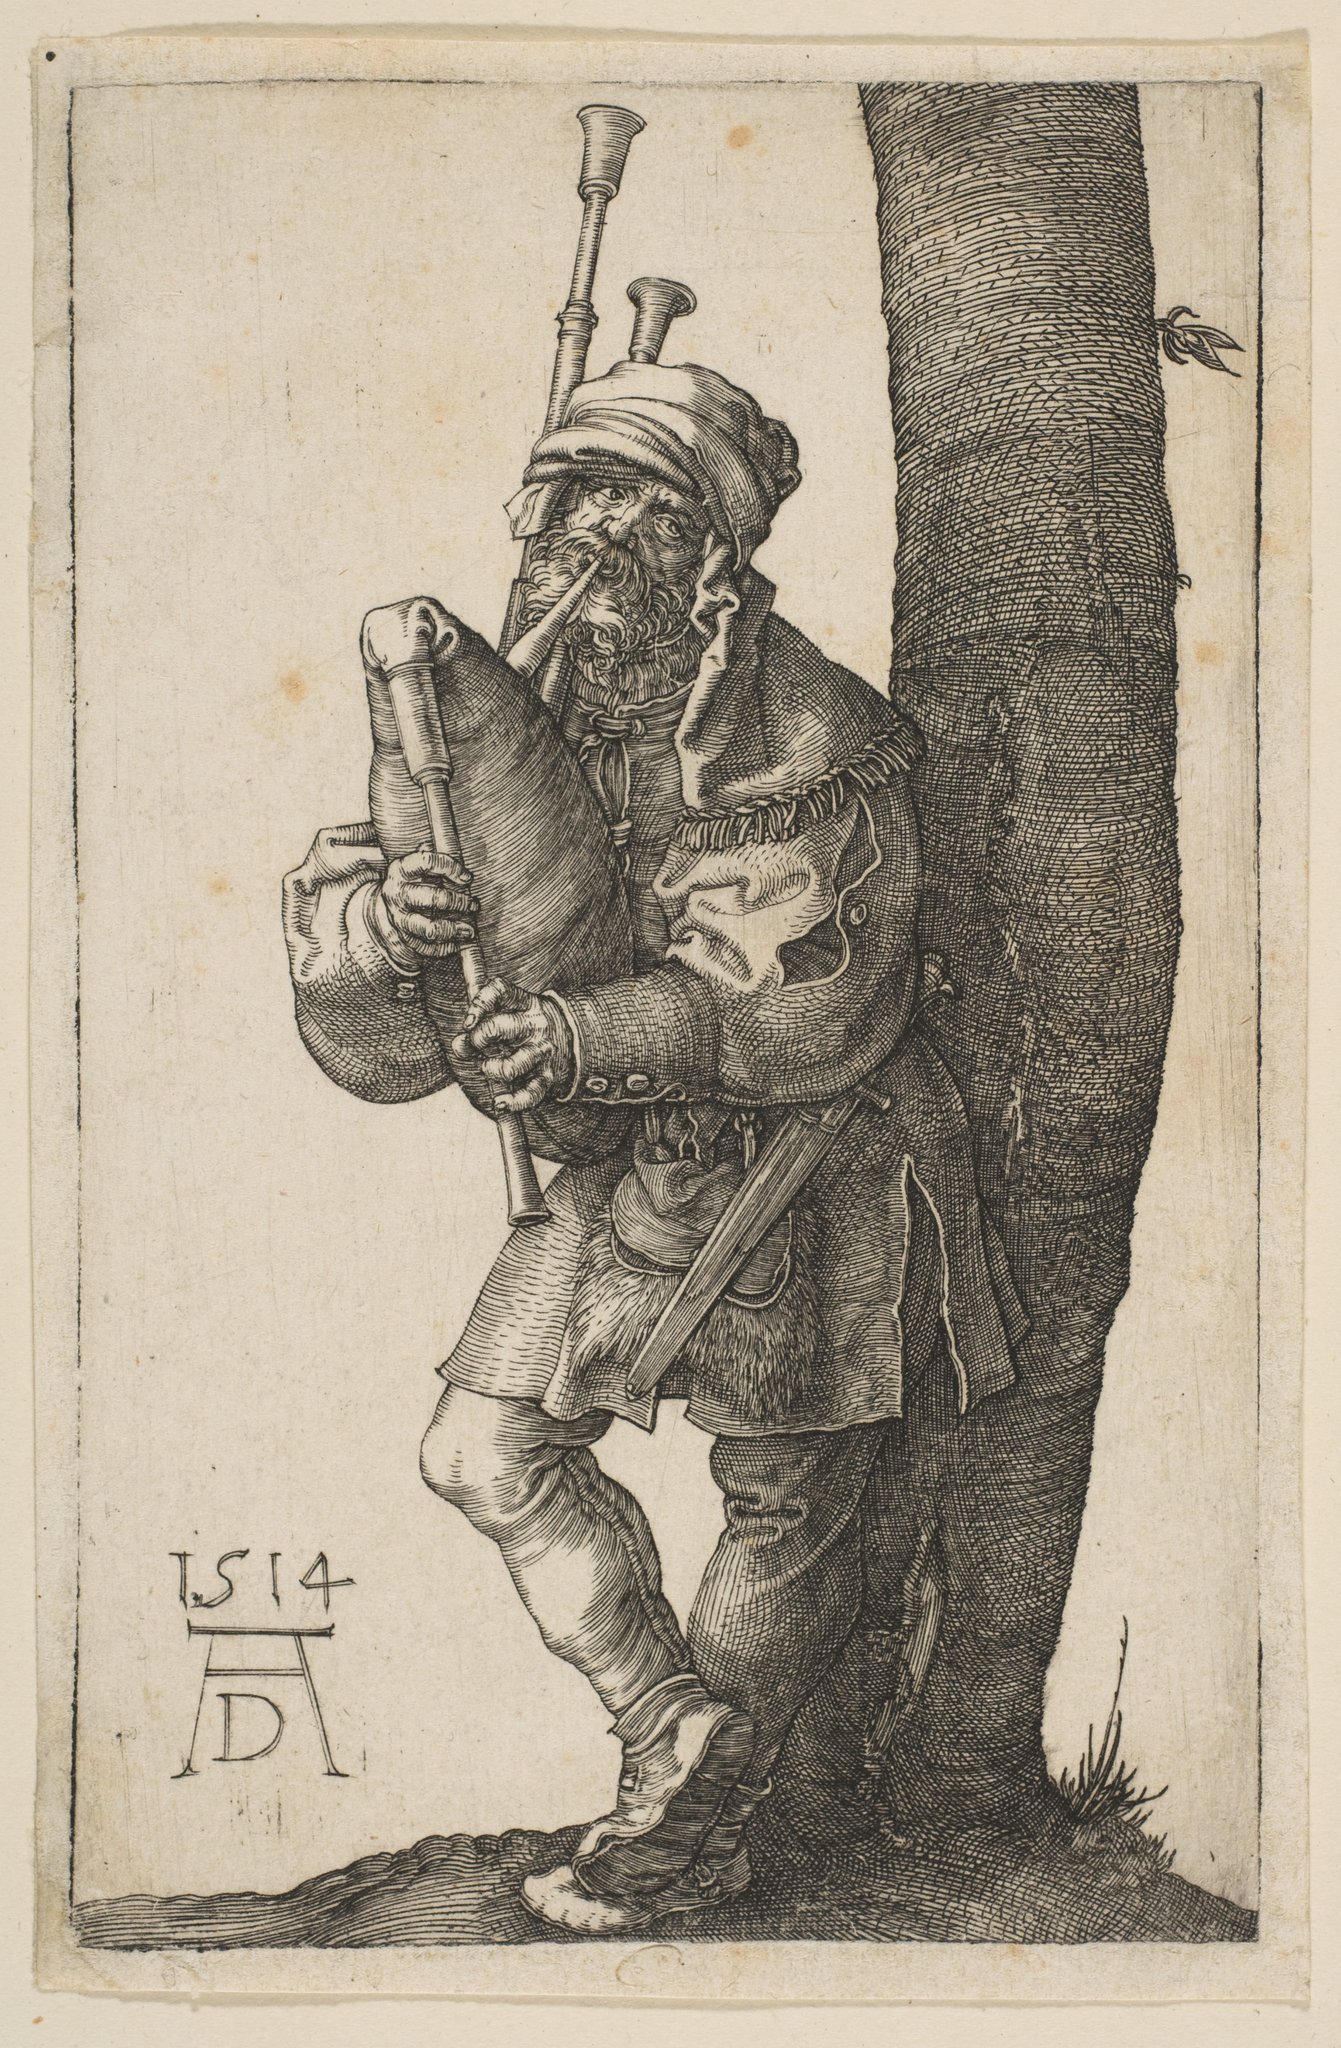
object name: print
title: The Bagpiper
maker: albrecht dürer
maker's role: artist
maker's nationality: german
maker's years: 1471-1528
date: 1514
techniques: engraving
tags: men,bagpipes